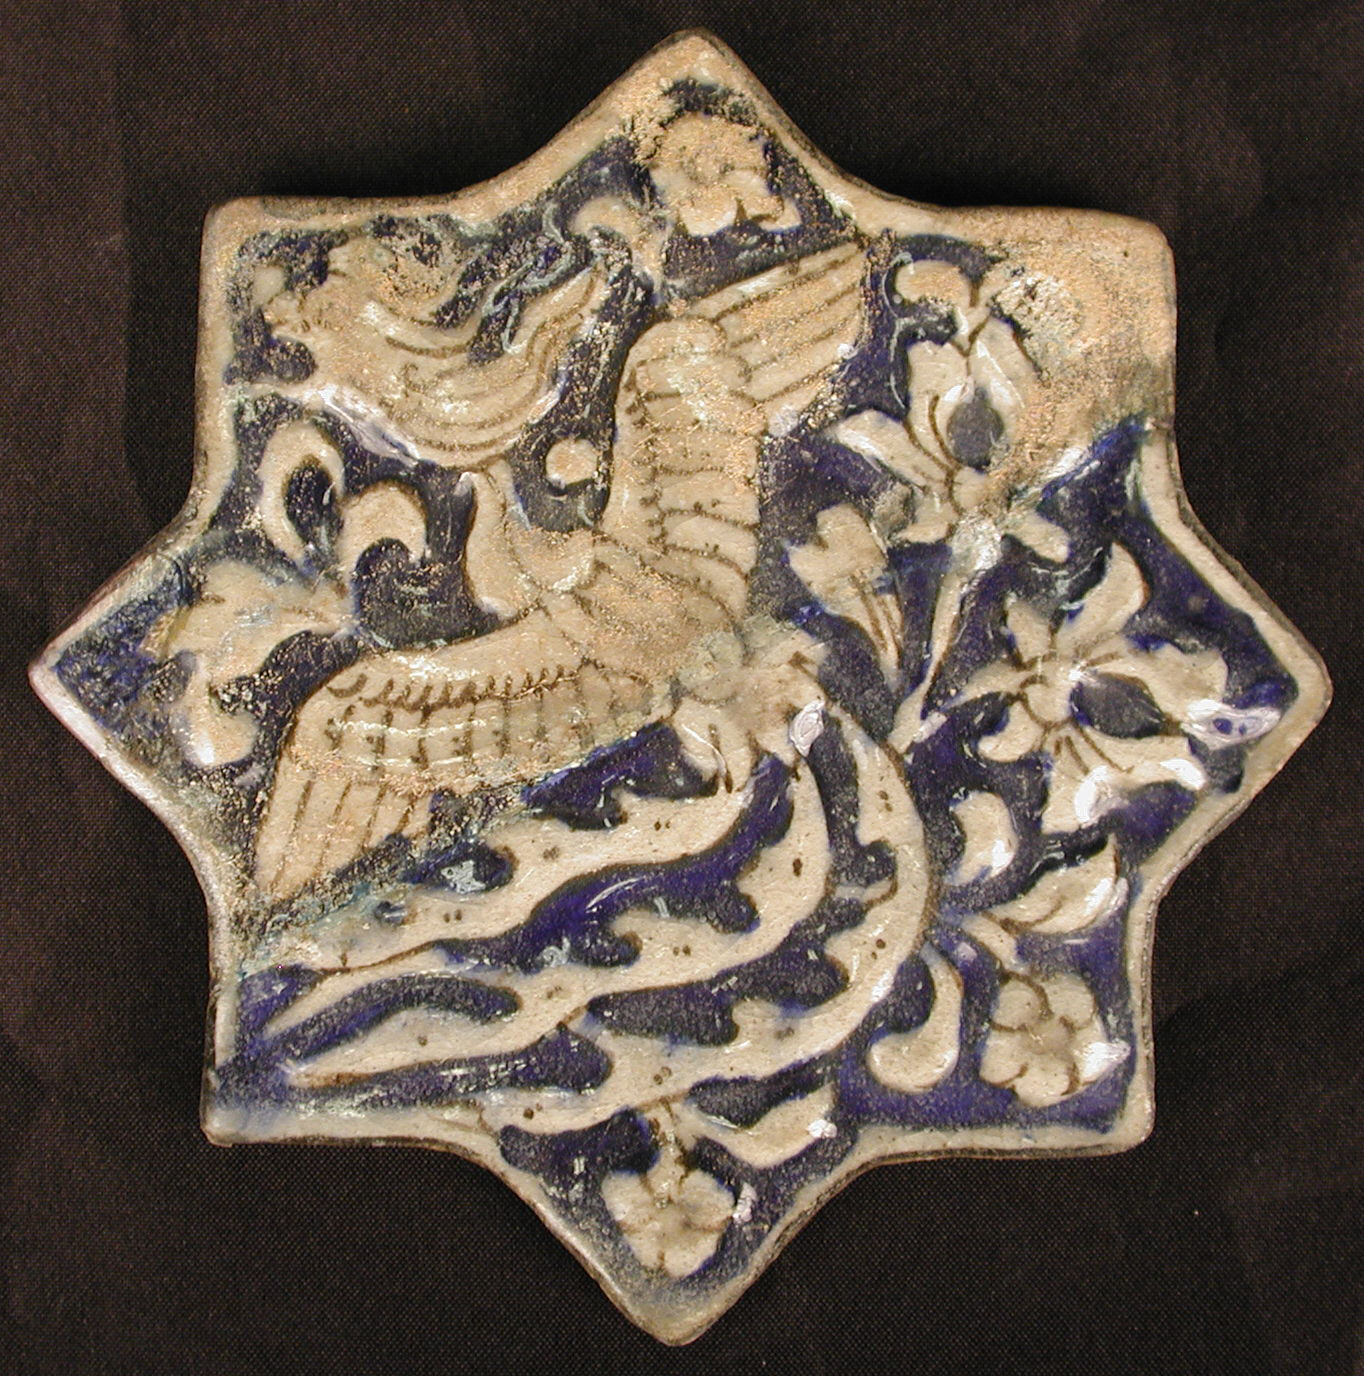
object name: tile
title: Star-Shaped Tile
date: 1301-1400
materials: stonepaste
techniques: painting, underglaze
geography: iran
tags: birds,flowers